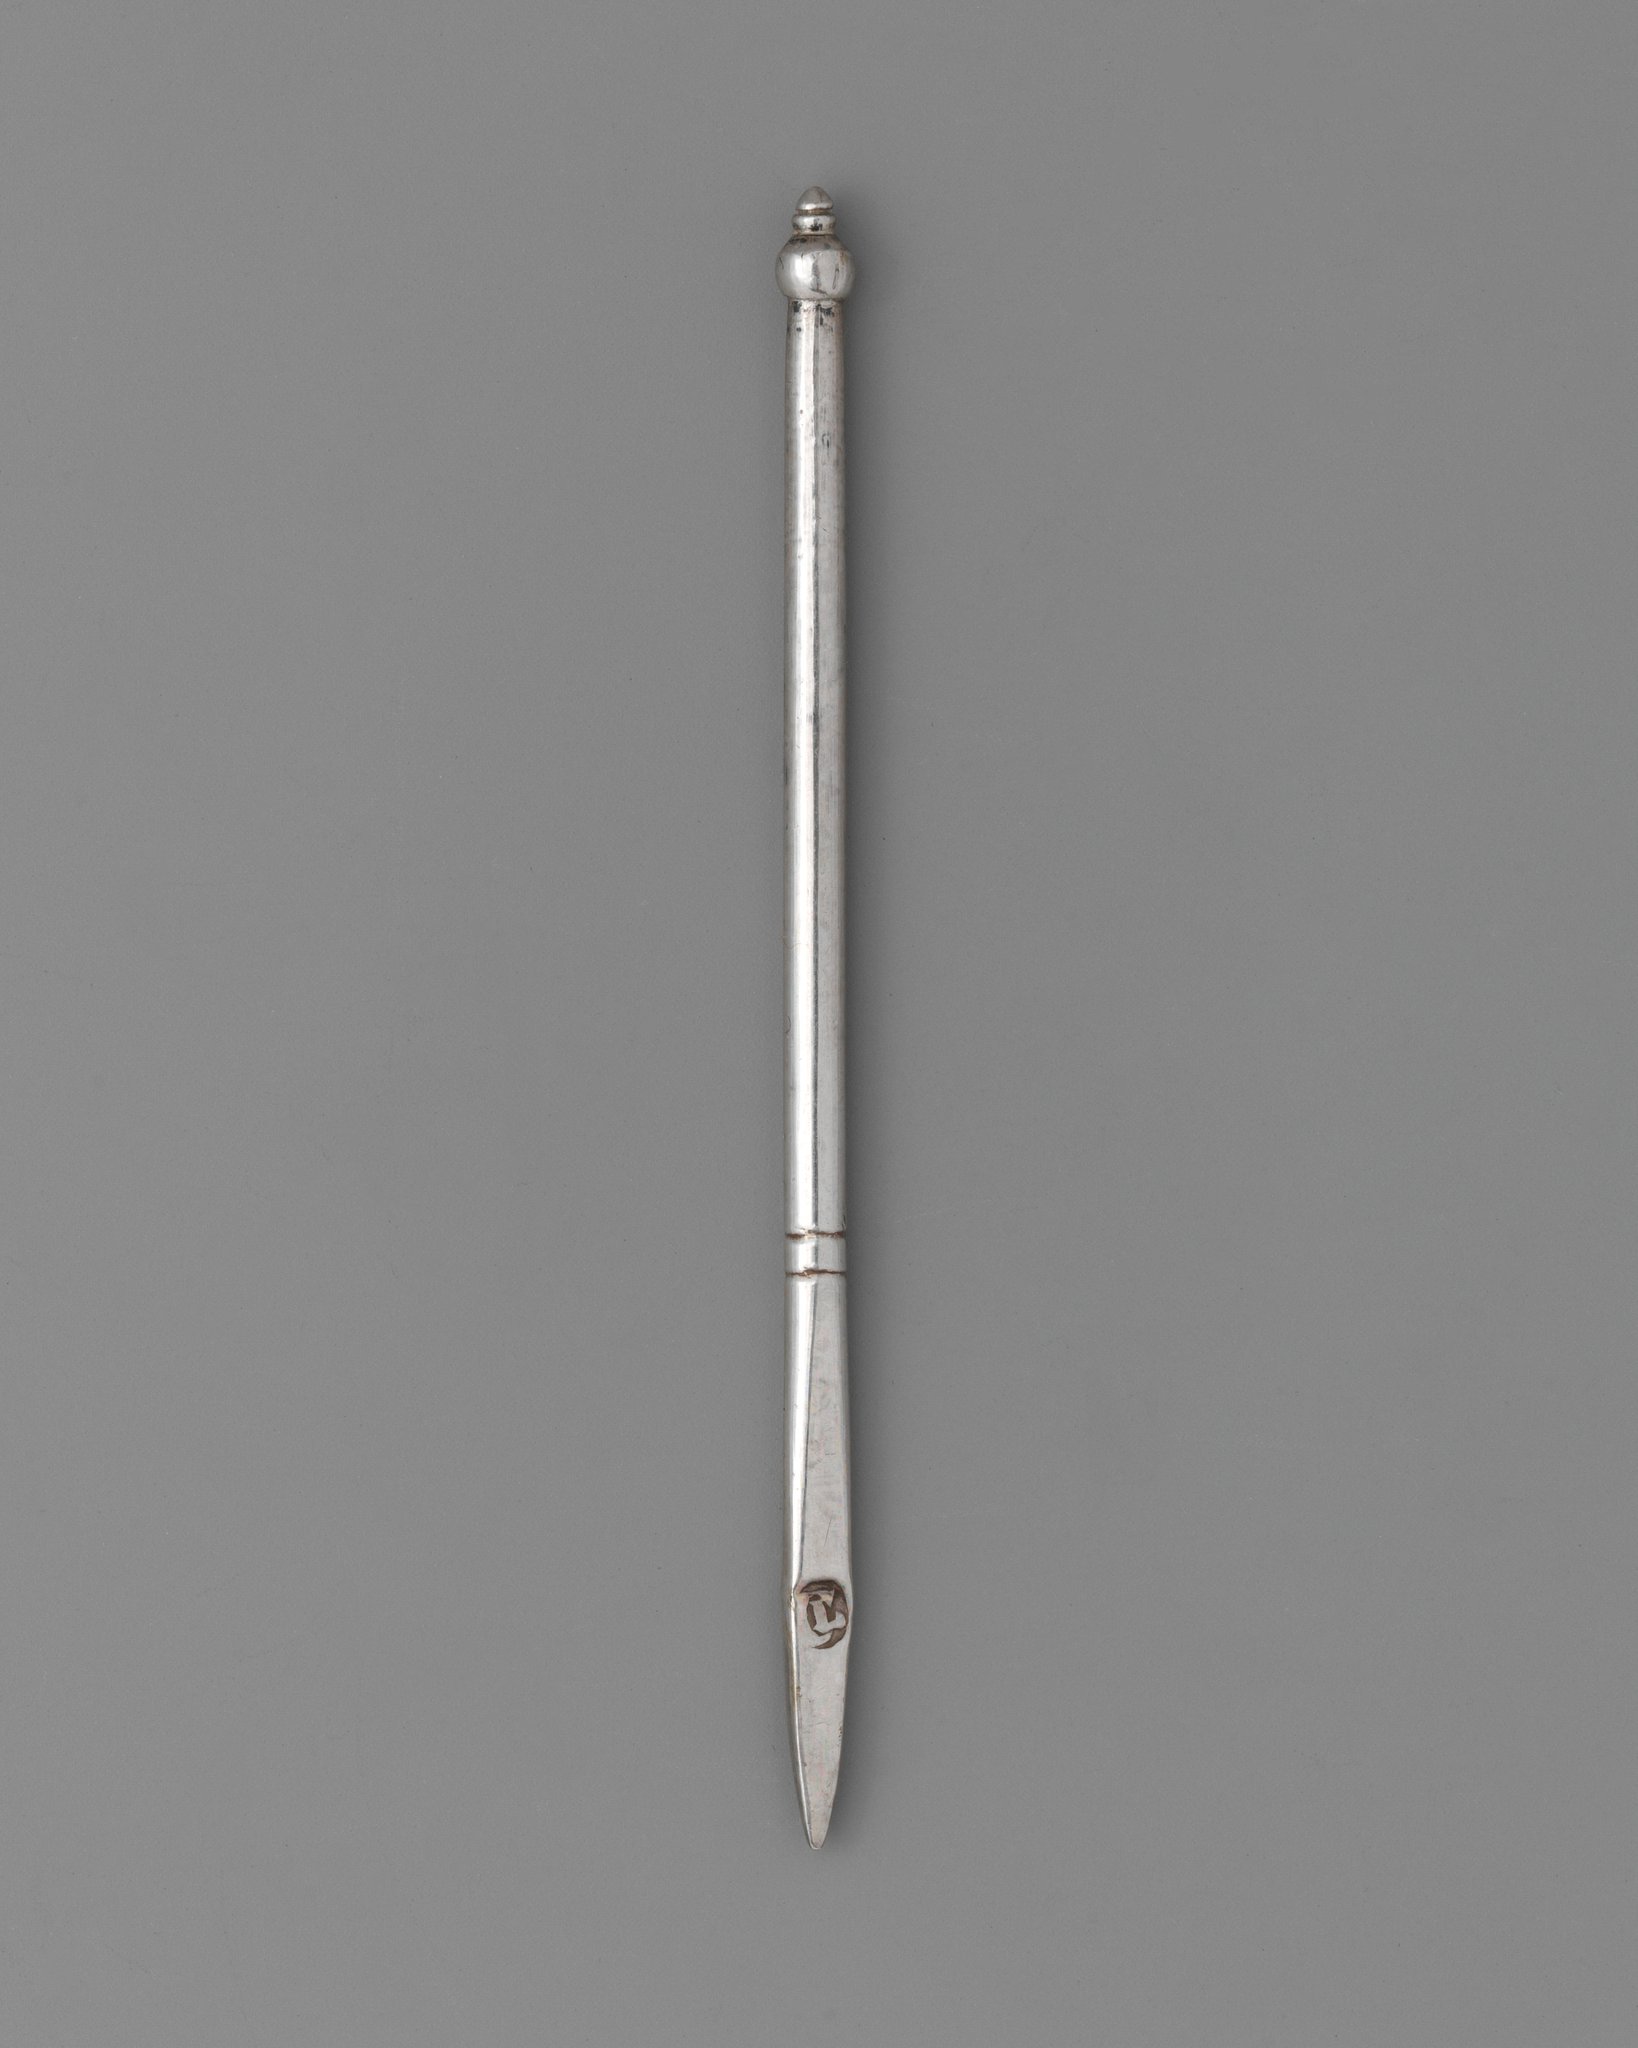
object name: poker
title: Miniature poker (part of a set)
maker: david clayton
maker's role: artist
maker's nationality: british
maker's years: 1659-1719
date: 1720-1730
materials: silver